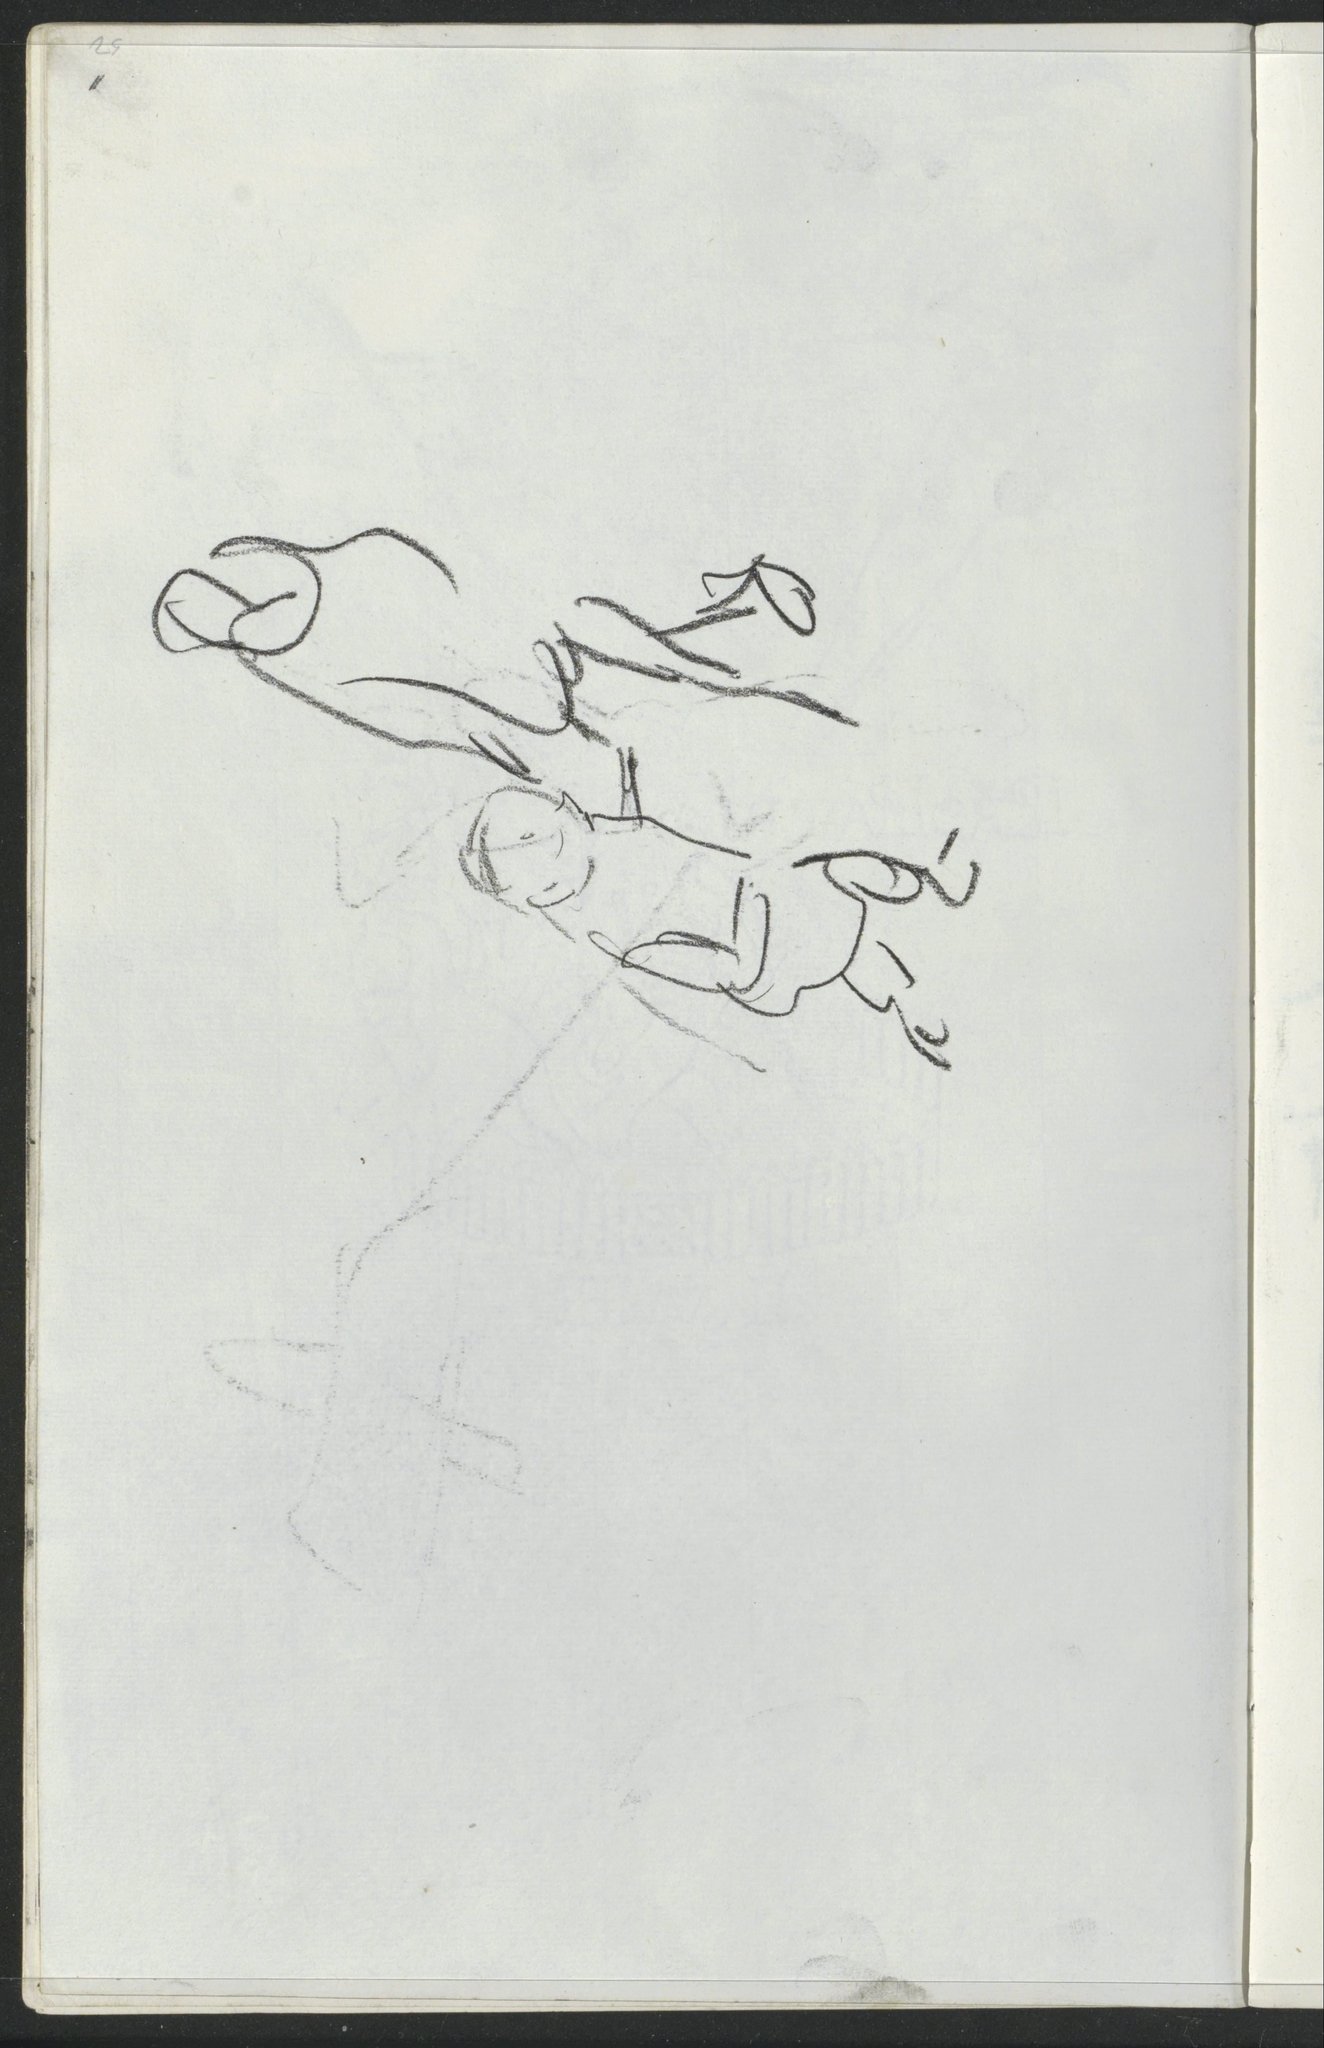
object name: sketchbook leaf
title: Twee figuurstudies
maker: isaac israels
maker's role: draughtsman, painter, print maker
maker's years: 1865-1934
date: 1875-1934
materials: chalk, paper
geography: amsterdam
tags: mother and child(ren), woman and child(ren) (family group)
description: Mogelijk een vrouw met kind. Blad 11 verso uit schetsboek XI met 30 bladen.